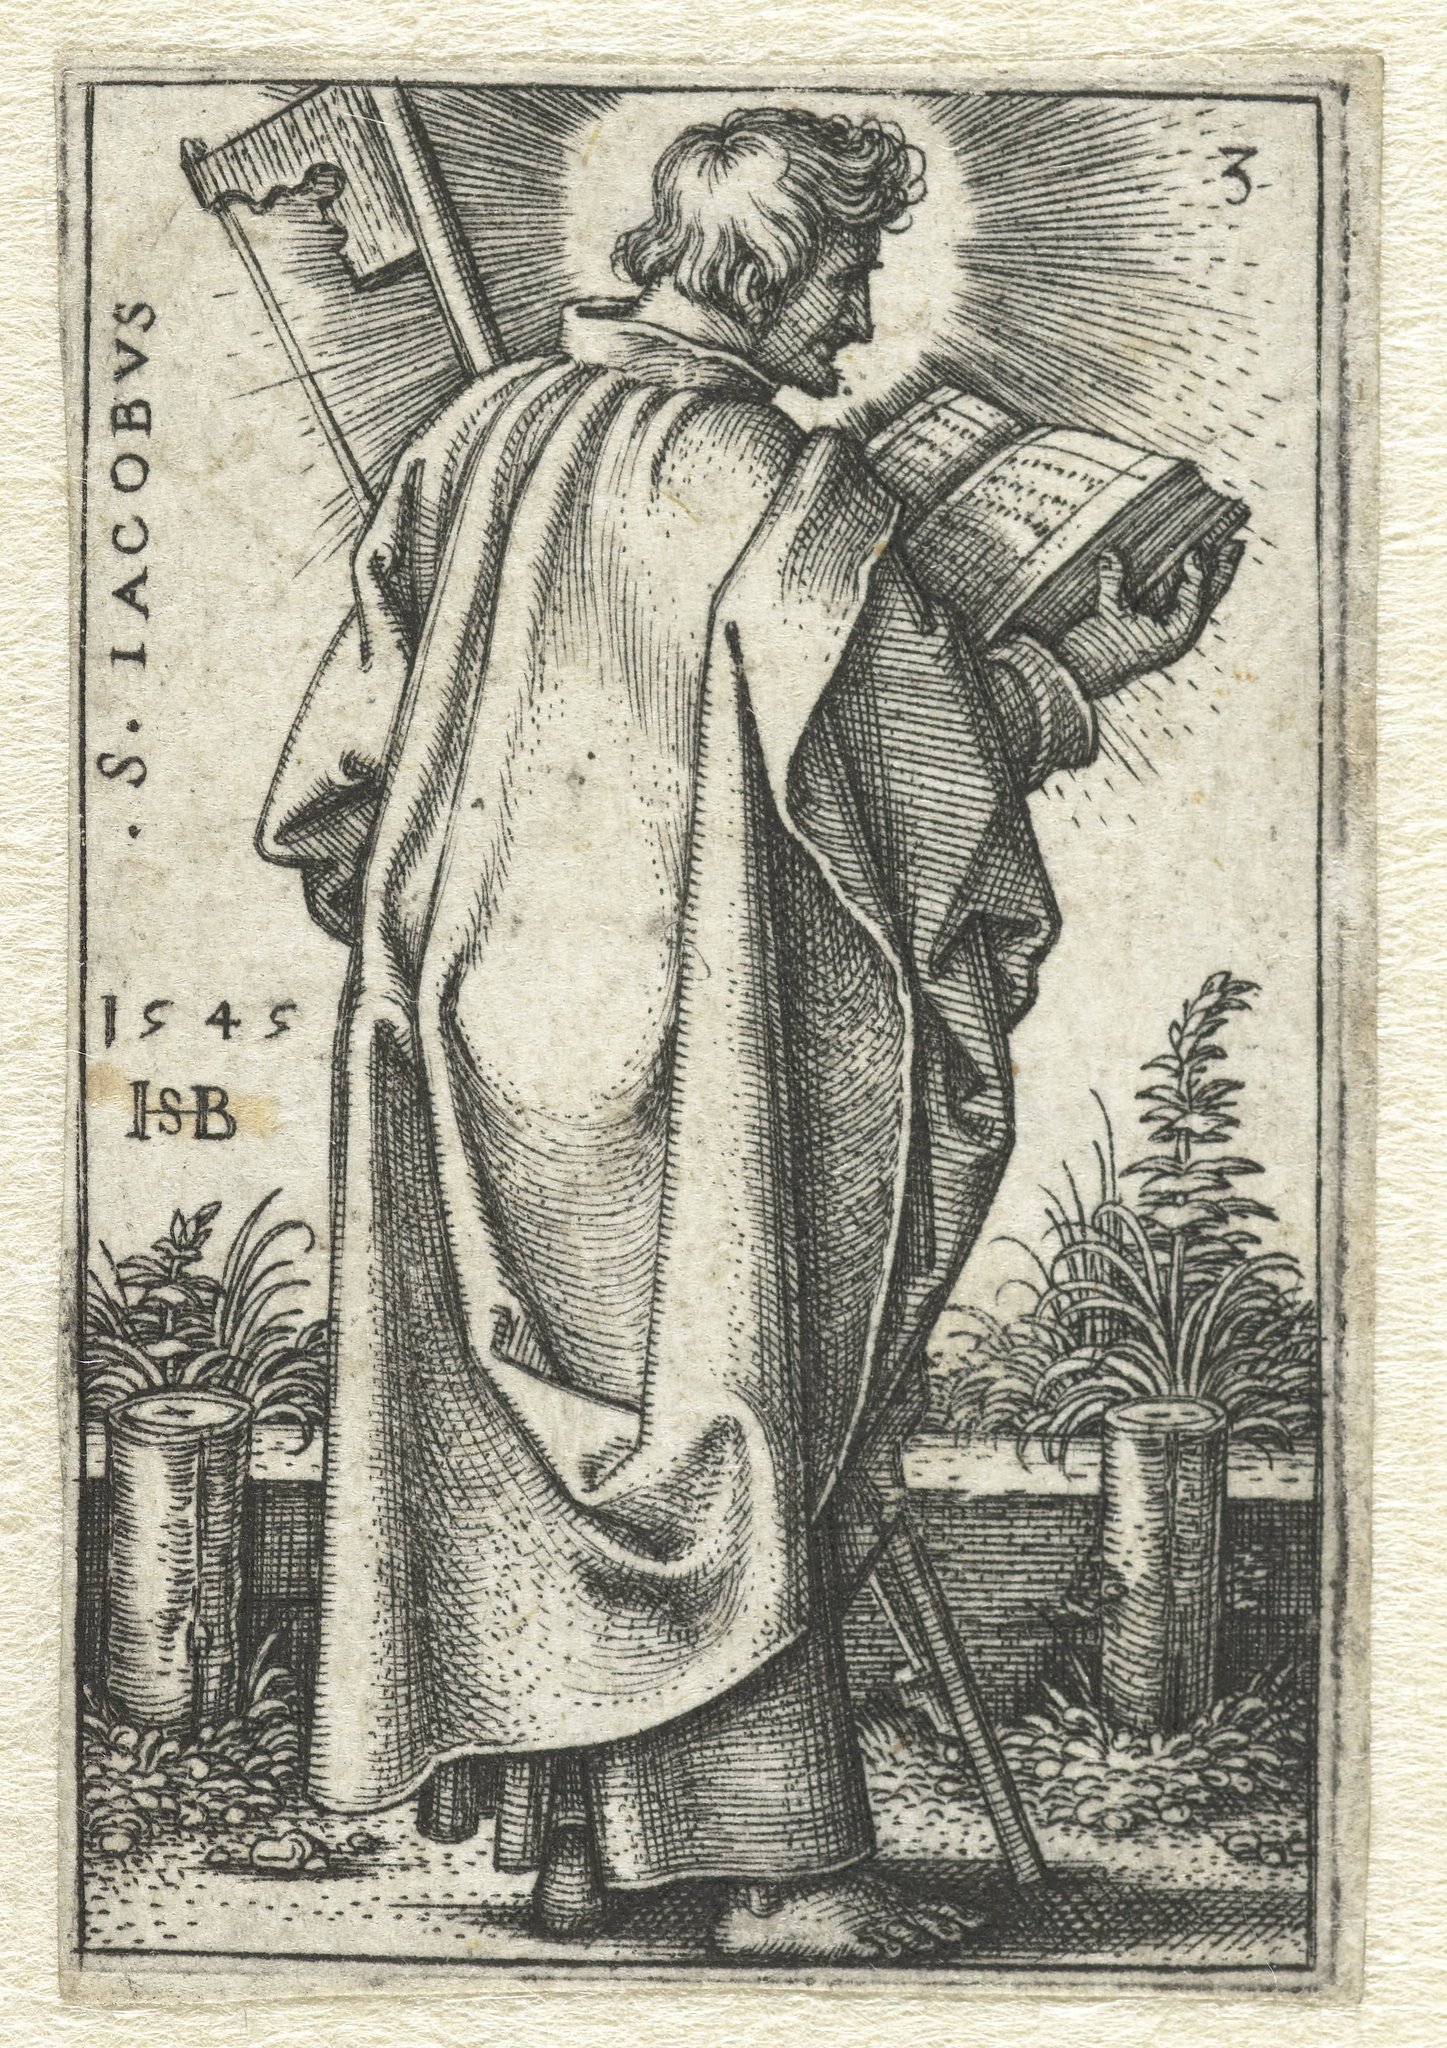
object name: print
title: Jakobus de Mindere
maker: hans sebald beham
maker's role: designer, draughtsman, print maker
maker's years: 1500-1550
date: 1545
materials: paper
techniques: engraving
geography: frankfurt am main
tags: the apostle james the less, first bishop of jerusalem; possible attributes: book, fuller's club, scroll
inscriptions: collector's mark: ‘Hinloopen’ Lugt 11